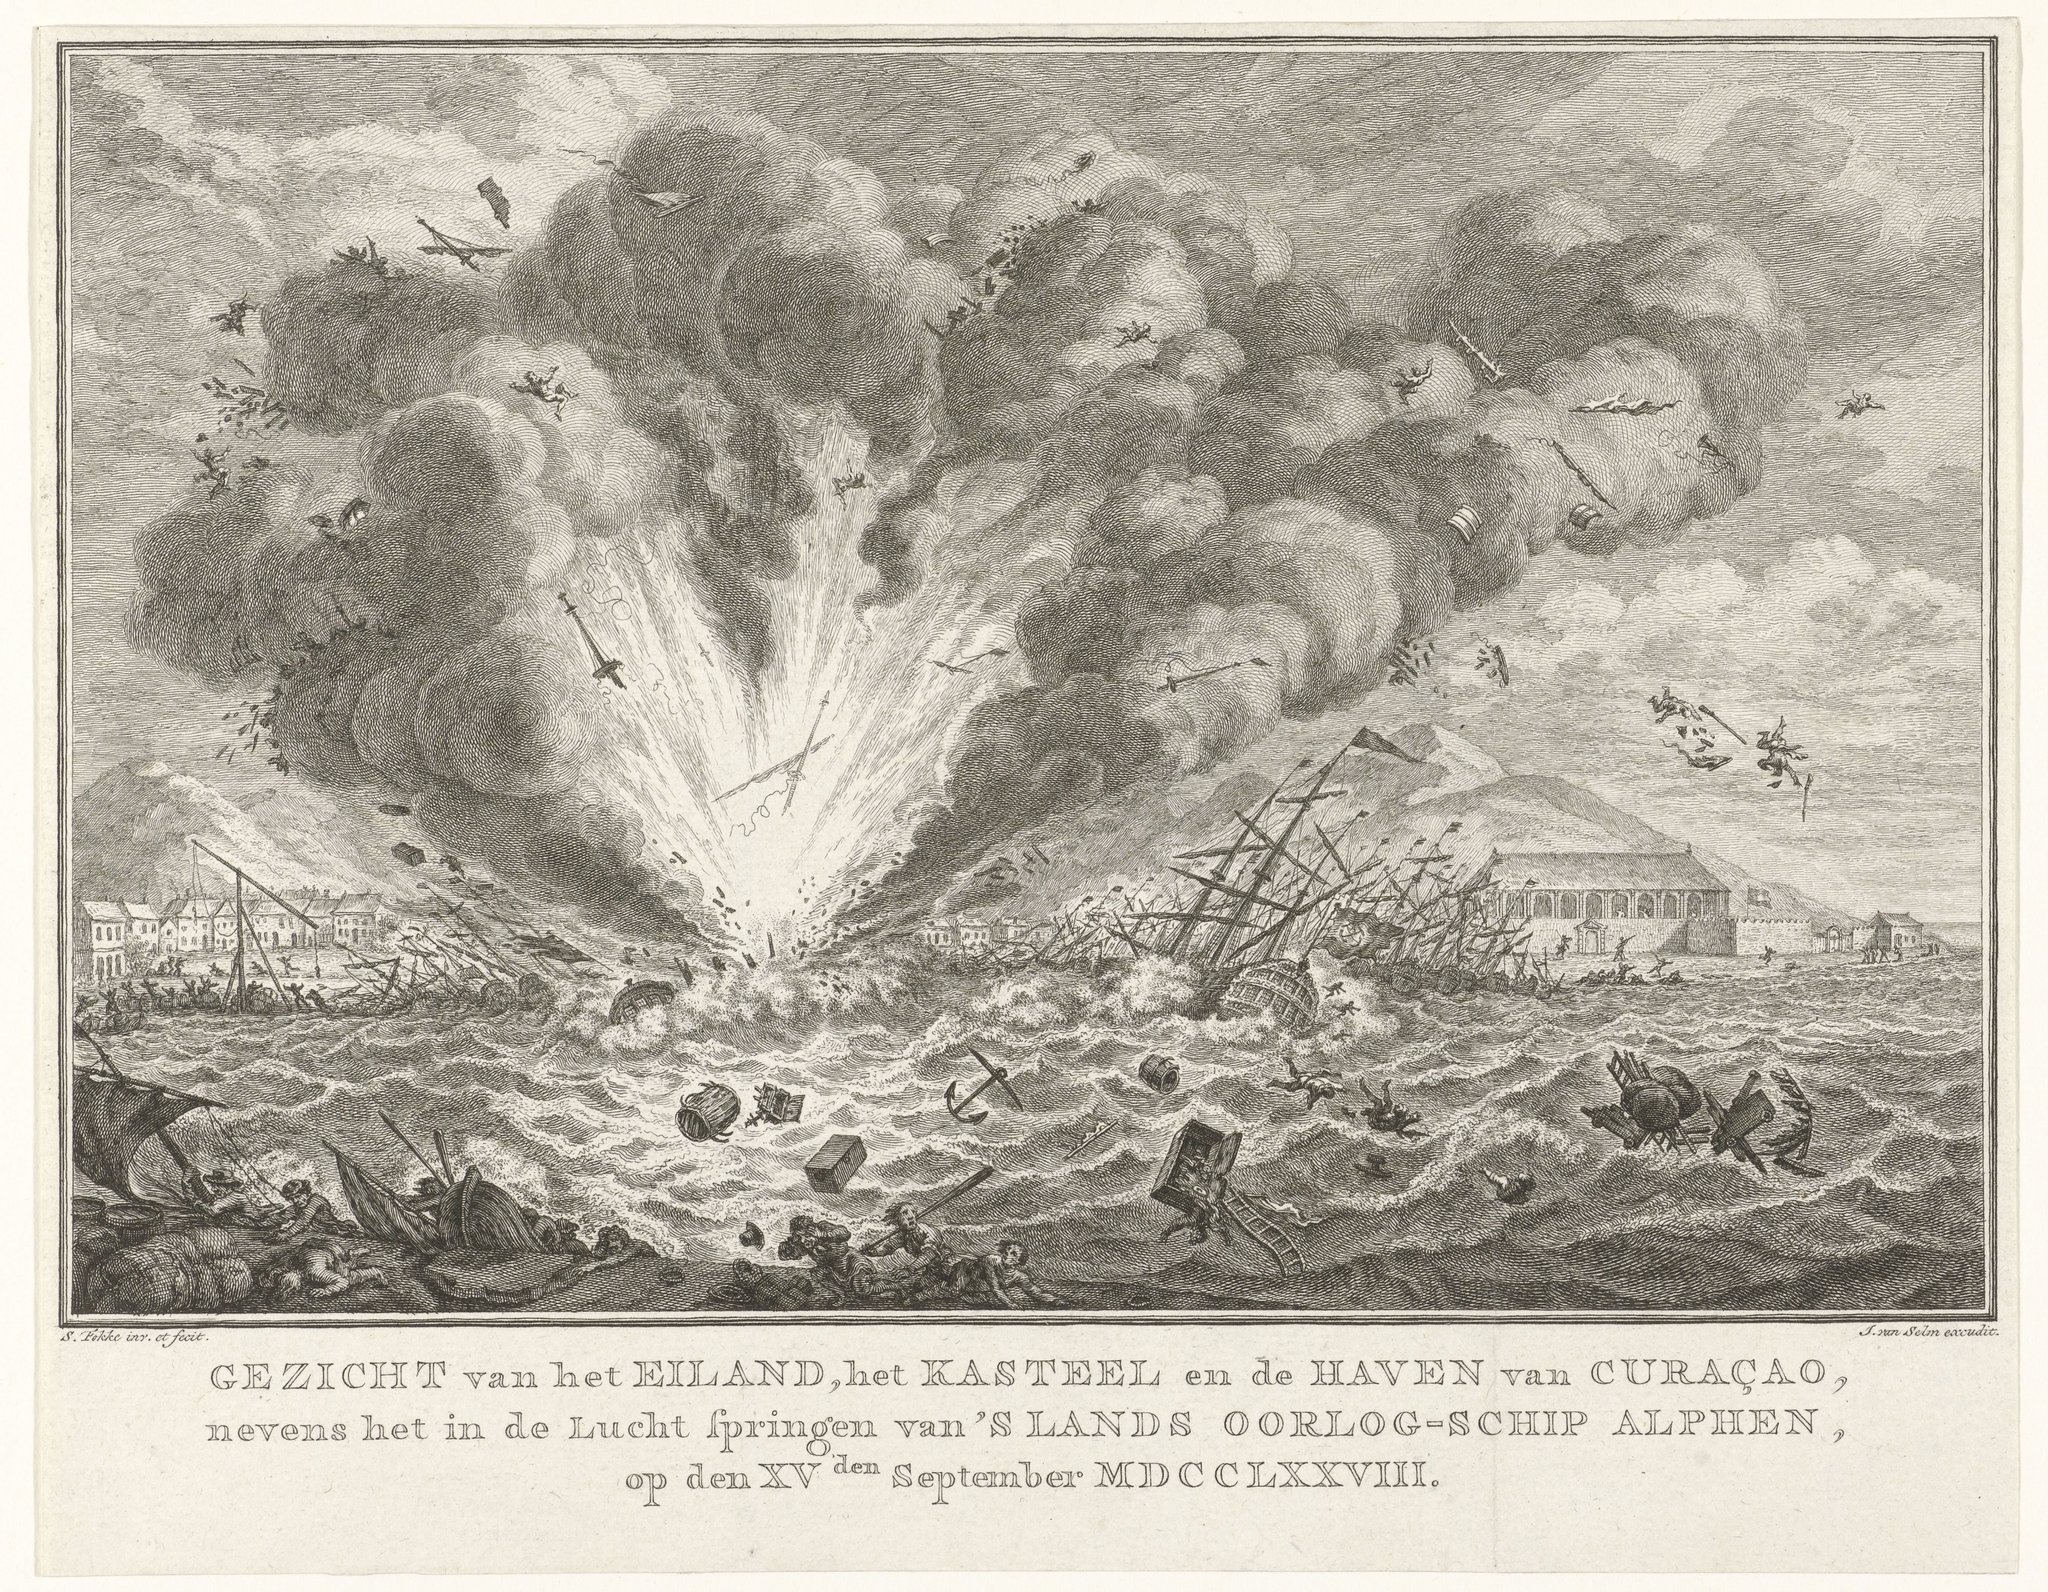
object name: print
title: Gezicht van het Eiland, het Kasteel en de Haven van Curaçao, nevens het in de Lucht springen van 's Lands Oorlog-schip Alphen, op den XVden September MDCCLXXVIII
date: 1779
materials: paper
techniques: engraving, etching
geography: northern netherlands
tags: gunpowder disaster (+ sailing-ships)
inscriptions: collector's mark: Lugt 2228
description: Het ontploffen van het fregat Alphen met de volledige bemanning van 206 man in de haven van Willemstad aan de St. Annabaai te Curaçao, 15 september 1778. Een explosie rijt het schip in stukken.